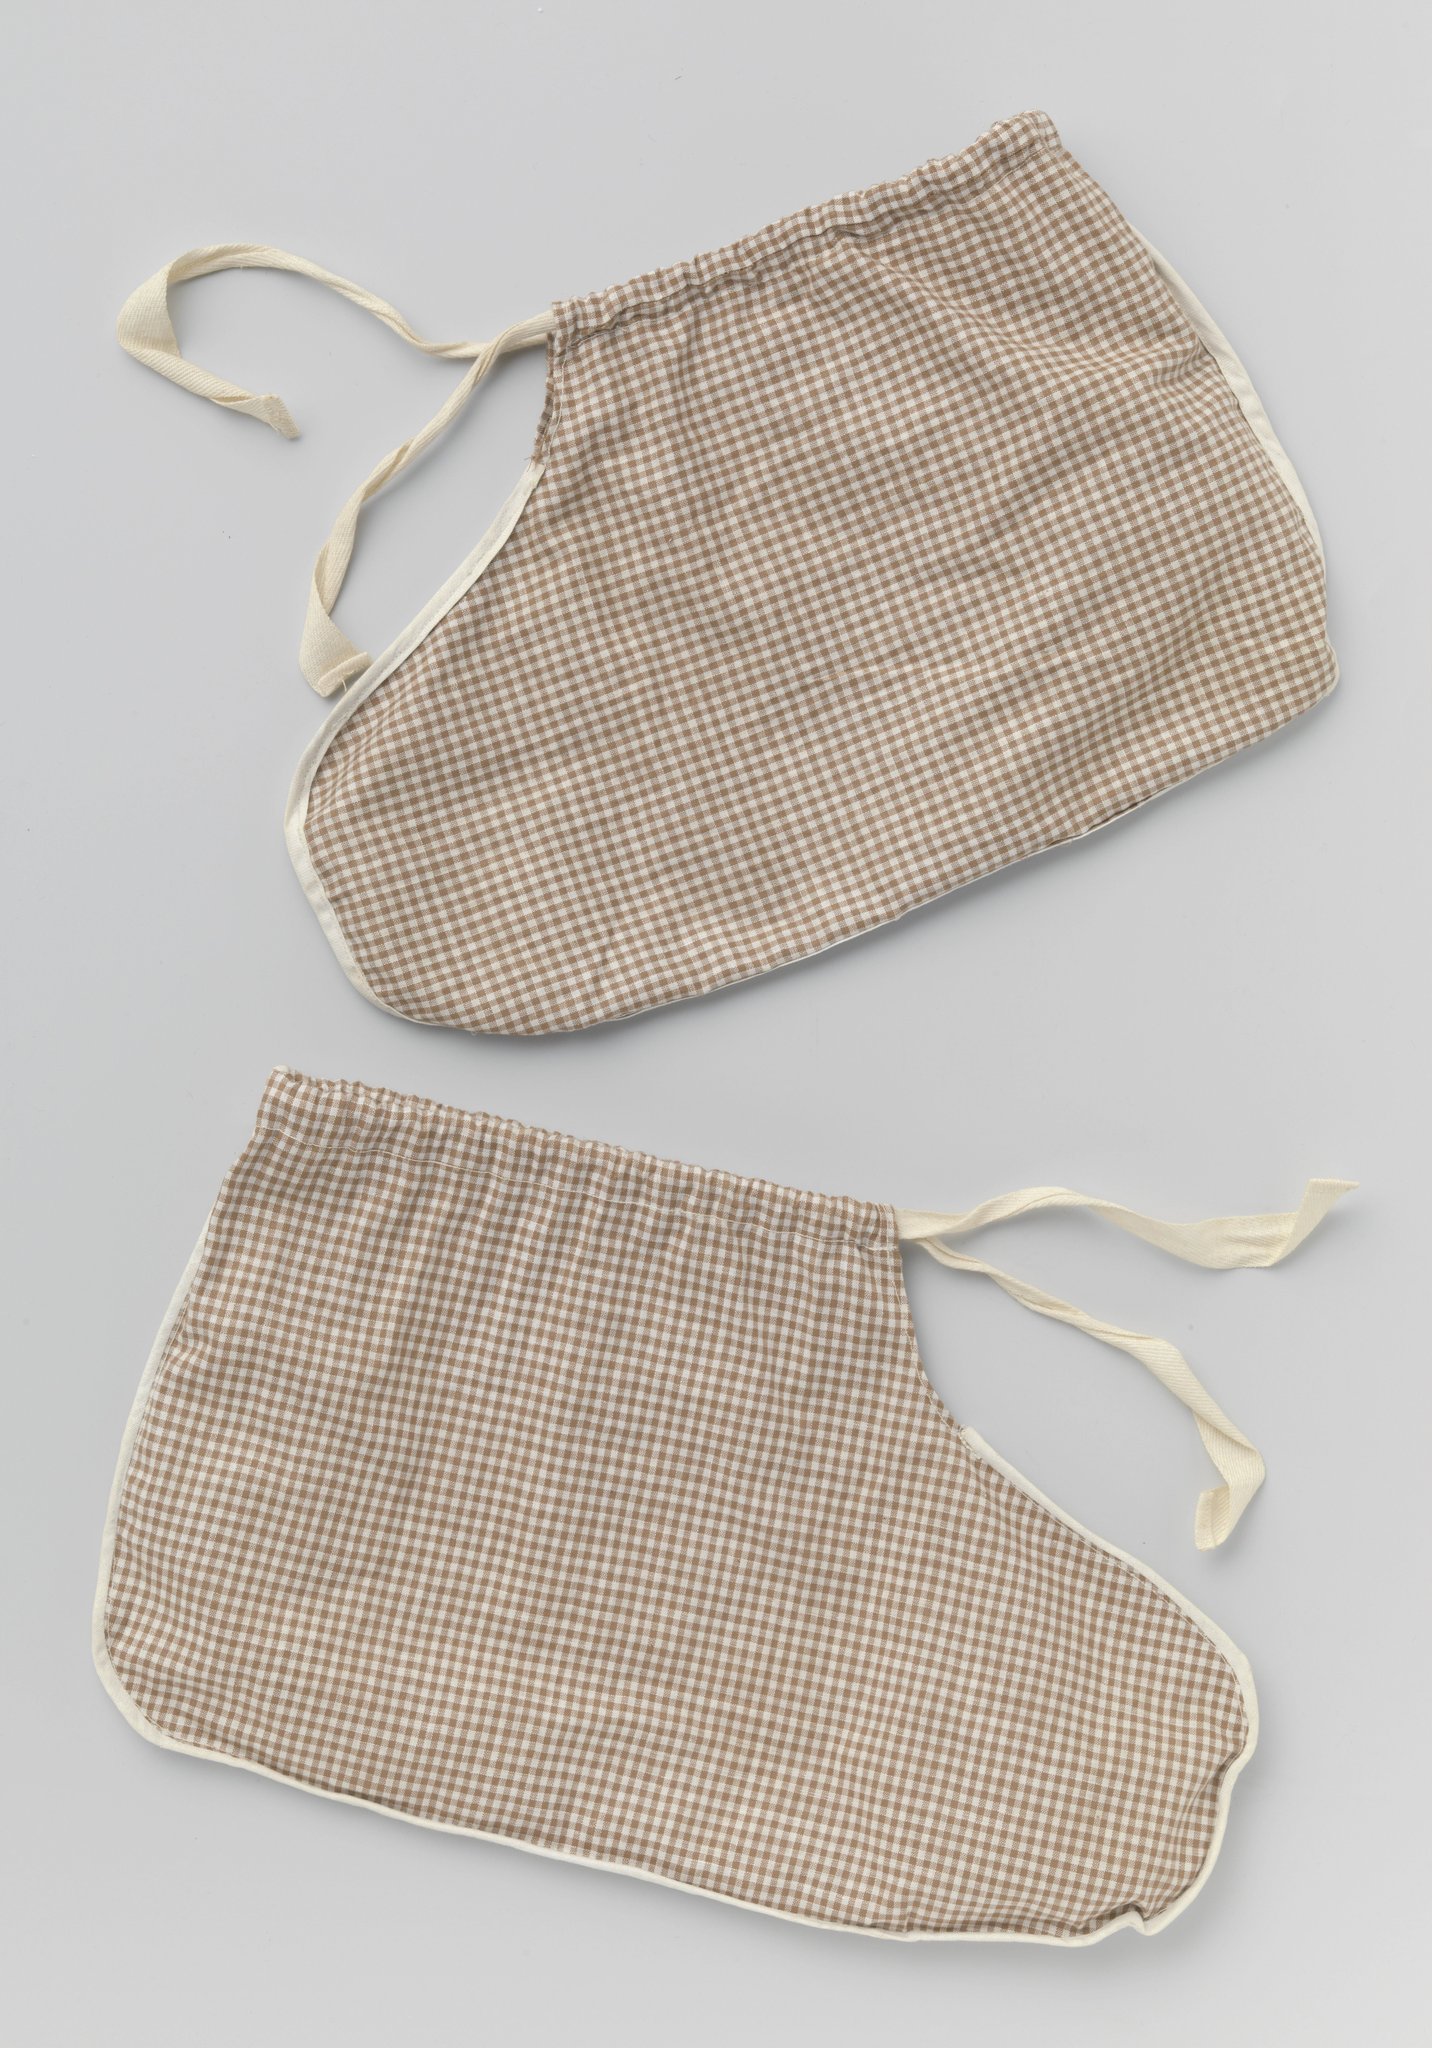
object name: shoe bag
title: Schoenenzak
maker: Anonymous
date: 1930-1970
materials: cotton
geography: western europe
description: Schoenenzak in bruin wit ruitjes patroon.